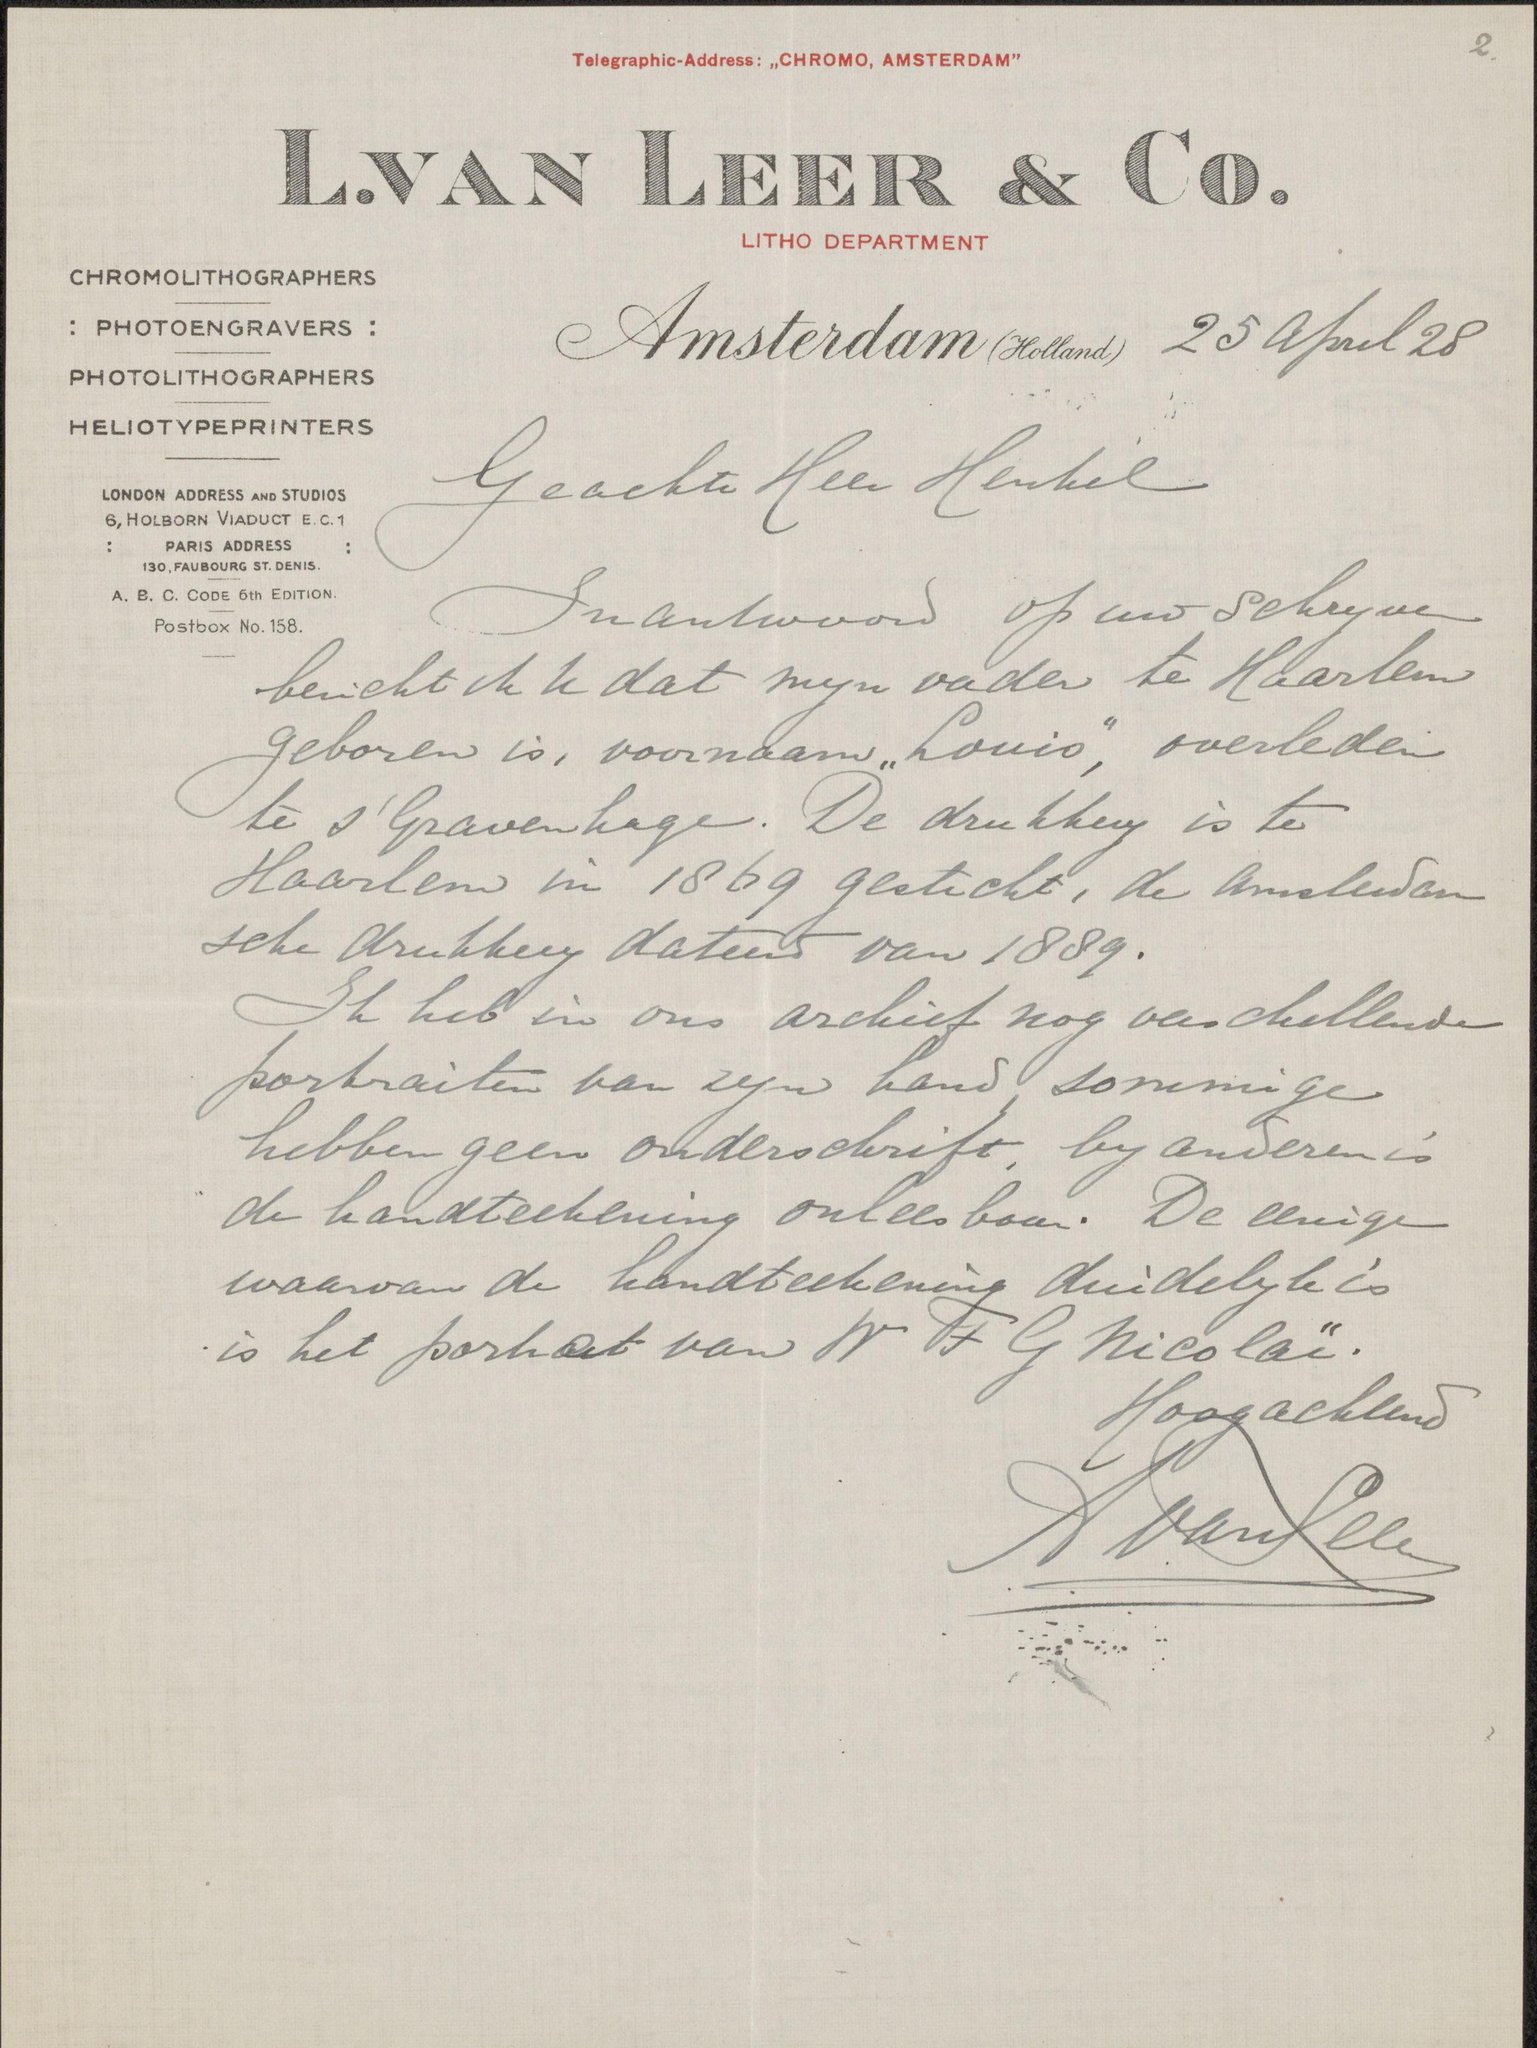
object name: letter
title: Brief aan Max Dittmar Henkel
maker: Anonymous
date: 1928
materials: ink, paper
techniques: pen, printing, writing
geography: amsterdam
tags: haarlem, the hague, louis van leer, max dittmar henkel, anonymous historical person portrayed, historical persons (portraits and scenes from the life), printed matter, amsterdam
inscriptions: watermark